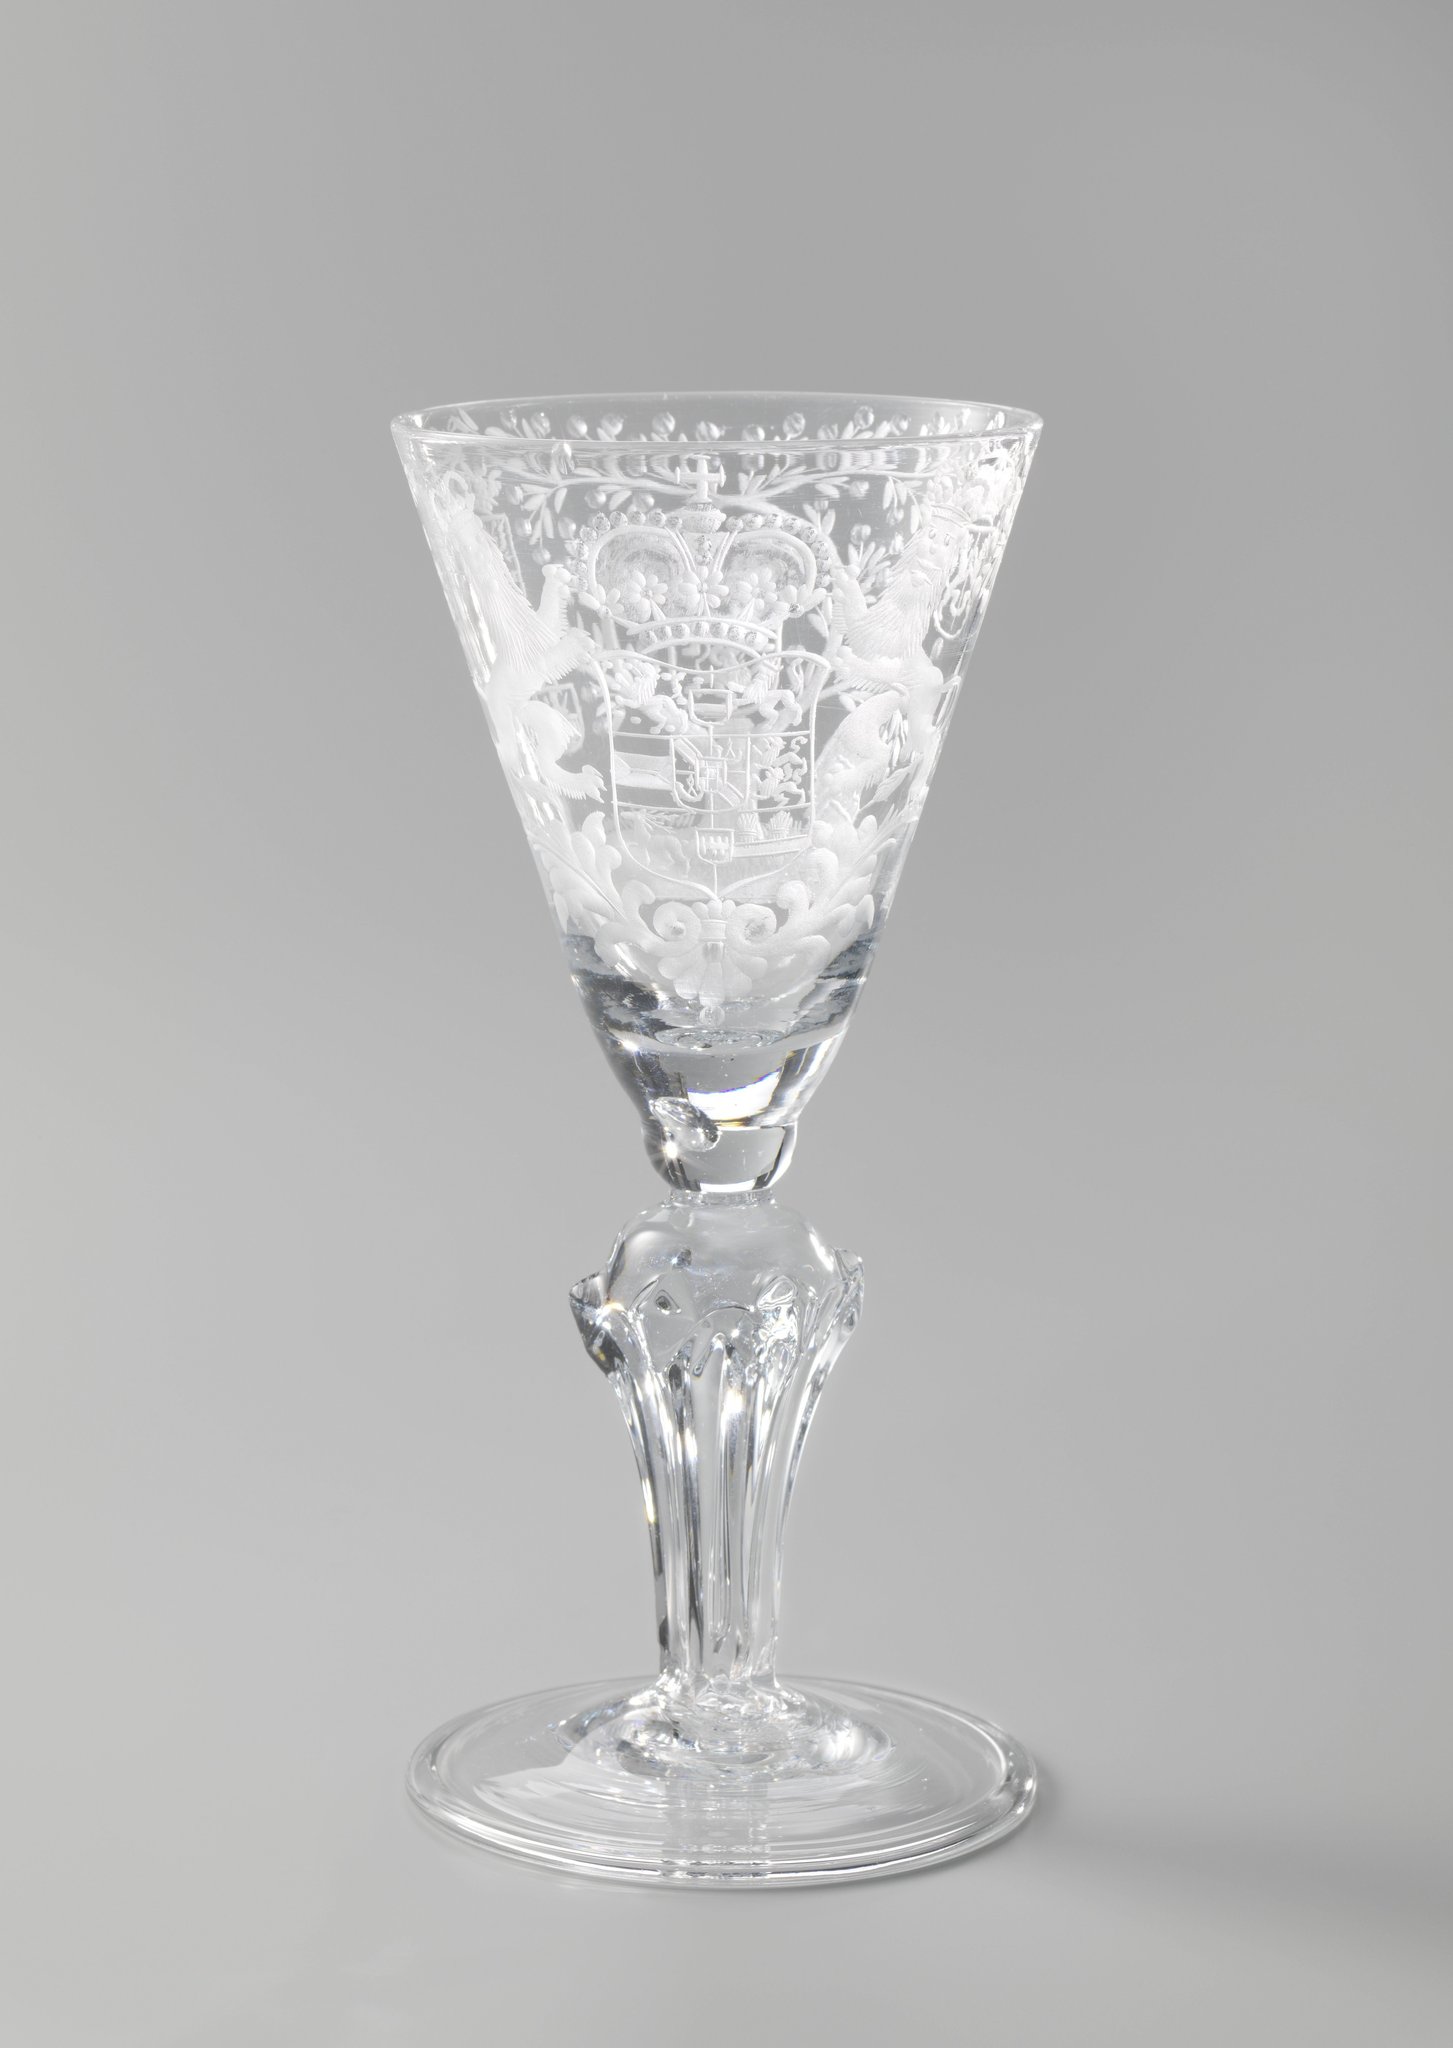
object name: goblet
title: Wine glass with the arms of William IV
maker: Anonymous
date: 1731-1747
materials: glass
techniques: glassblowing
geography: england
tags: the hague, willem iv (prins van oranje-nassau), coat of arms (symbol of sovereignty)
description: Gewelfde voet. Zeshoekige in vorm geblazen stam met een knoop. Conische kelk met massieve, afgeronde bodem met een luchtbel. Op de kelk het wapen van Willem IV, prins van Oranje. Op de keerzijde een oranjeboom met de wapens van Friesland, Groningen, Drenthe en Gelderland.